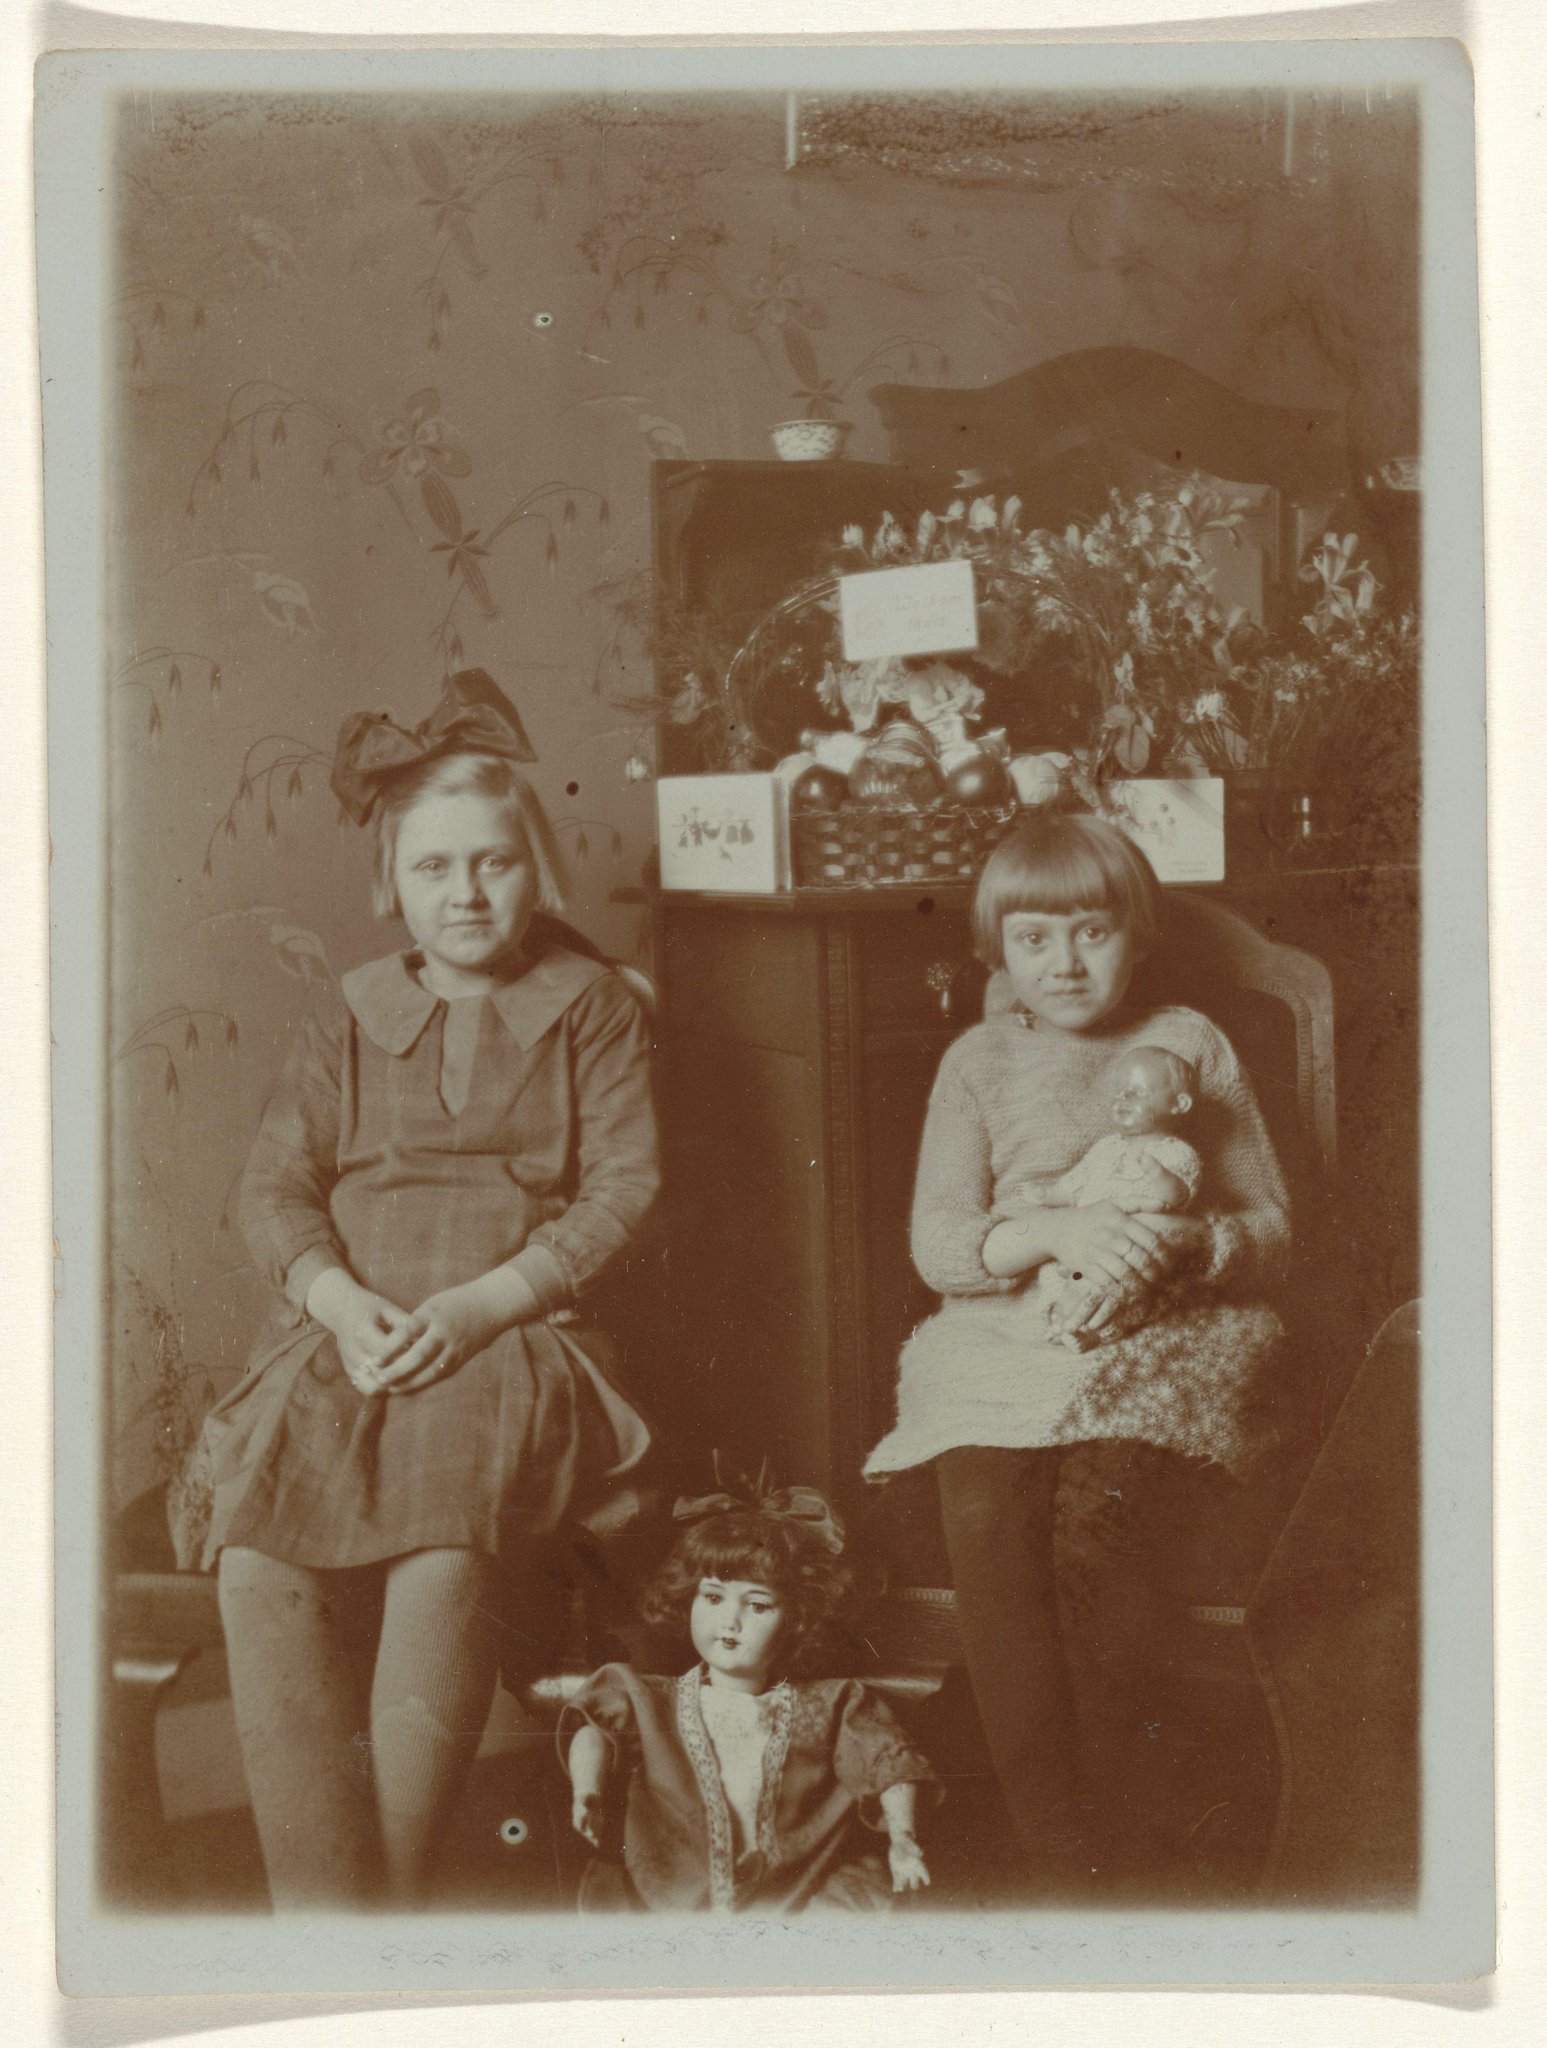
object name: photograph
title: Portret van twee onbekende zittende meisjes in een interieur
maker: Anonymous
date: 1925-1935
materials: paper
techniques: gelatin silver print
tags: historical persons, girl (child between toddler and youth) (+ two persons)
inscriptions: inscription: ‘A5’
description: Portret van 2 meisjes, zittend op een stoel, in een huiselijk interieur.